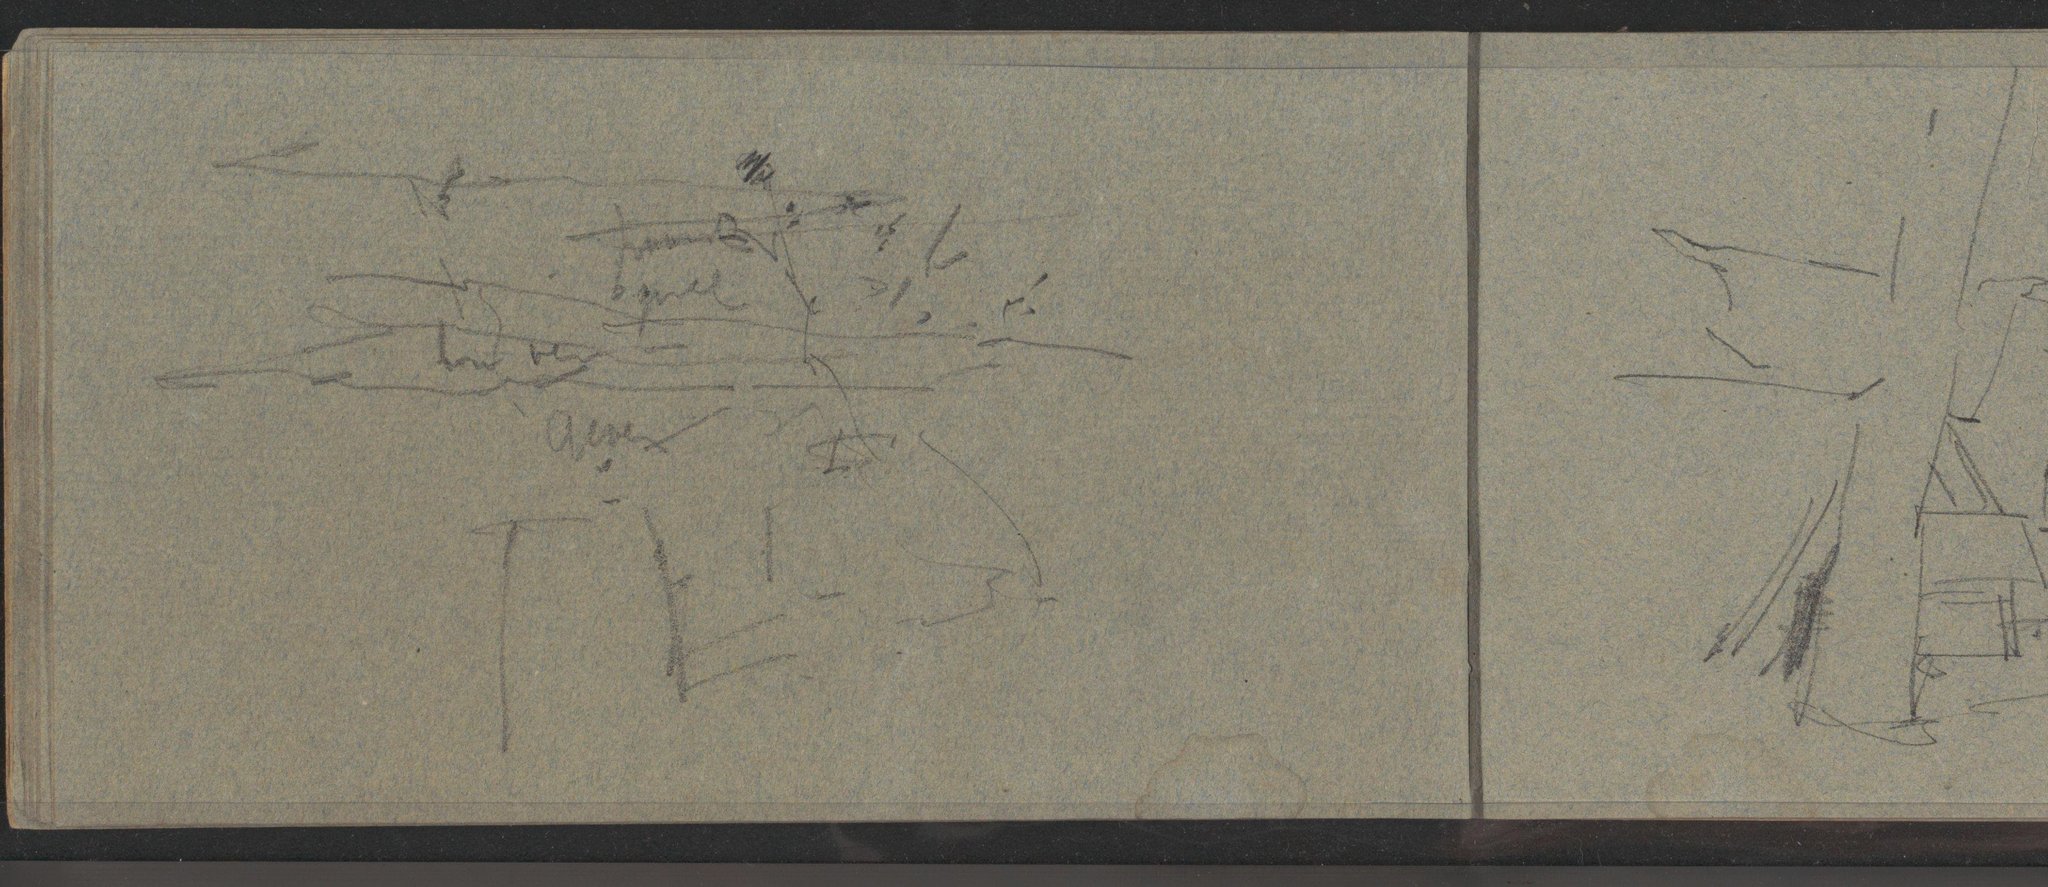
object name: sketchbook leaf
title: Landschap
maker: george hendrik breitner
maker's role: draughtsman, painter, print maker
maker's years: 1857-1923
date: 1883-1885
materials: paper, pencil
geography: the hague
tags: landscapes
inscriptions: kleurnotitie, handgeschreven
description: Blad 5 verso uit een schetsboek met 36 bladen.